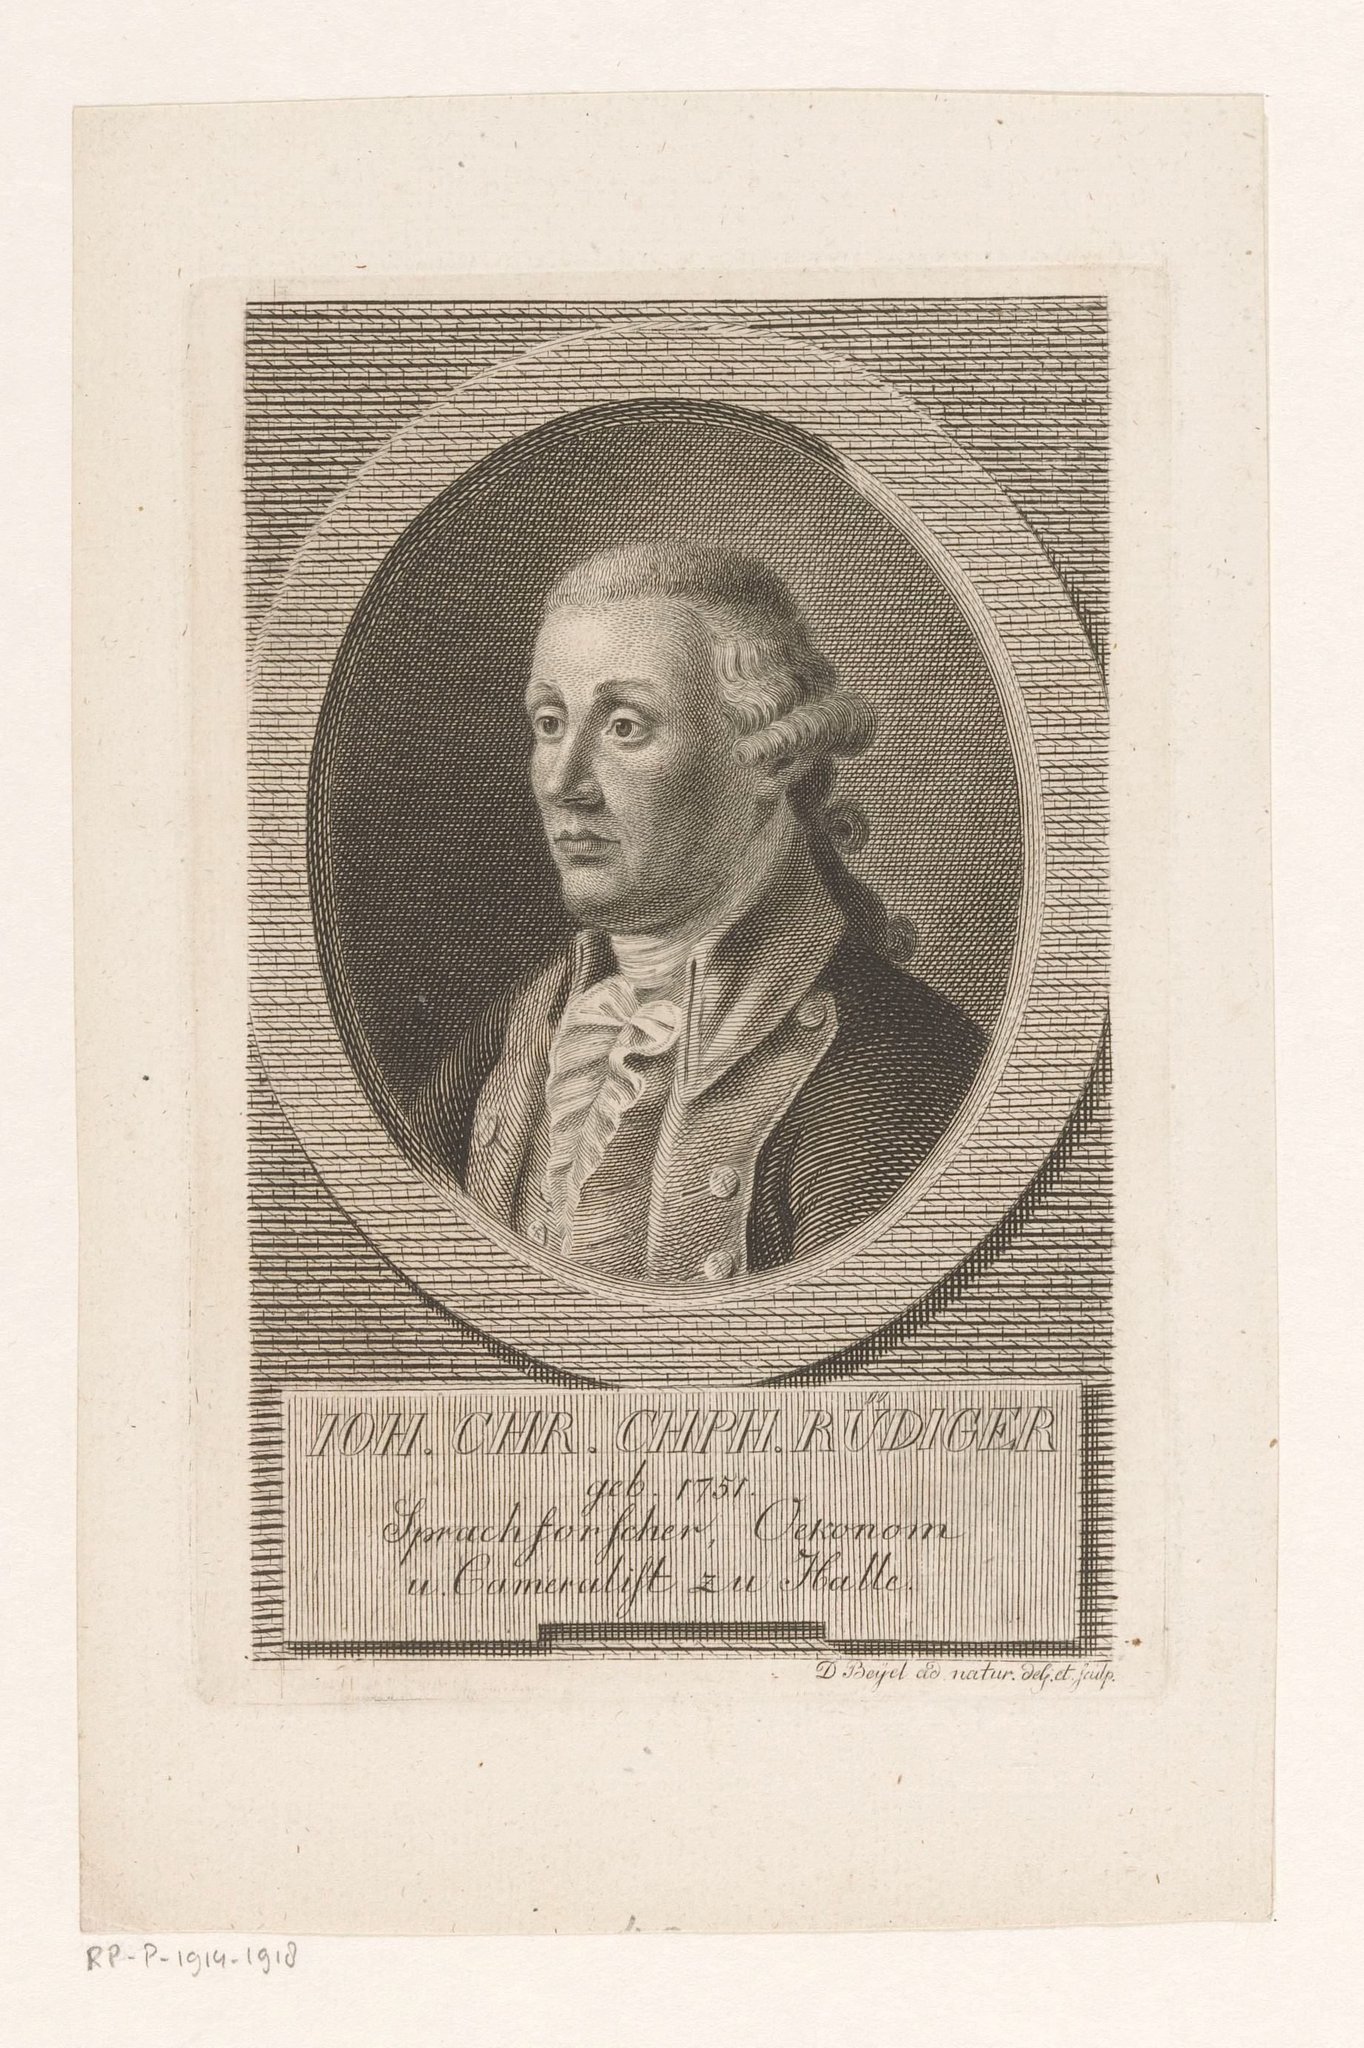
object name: print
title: Portret van Johann Christian Christoph Rüdiger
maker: daniel beyel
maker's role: draughtsman, print maker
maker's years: 1760-1823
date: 1785-1823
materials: paper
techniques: engraving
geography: halle an der saale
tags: historical persons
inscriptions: collector's mark: Lugt 2228